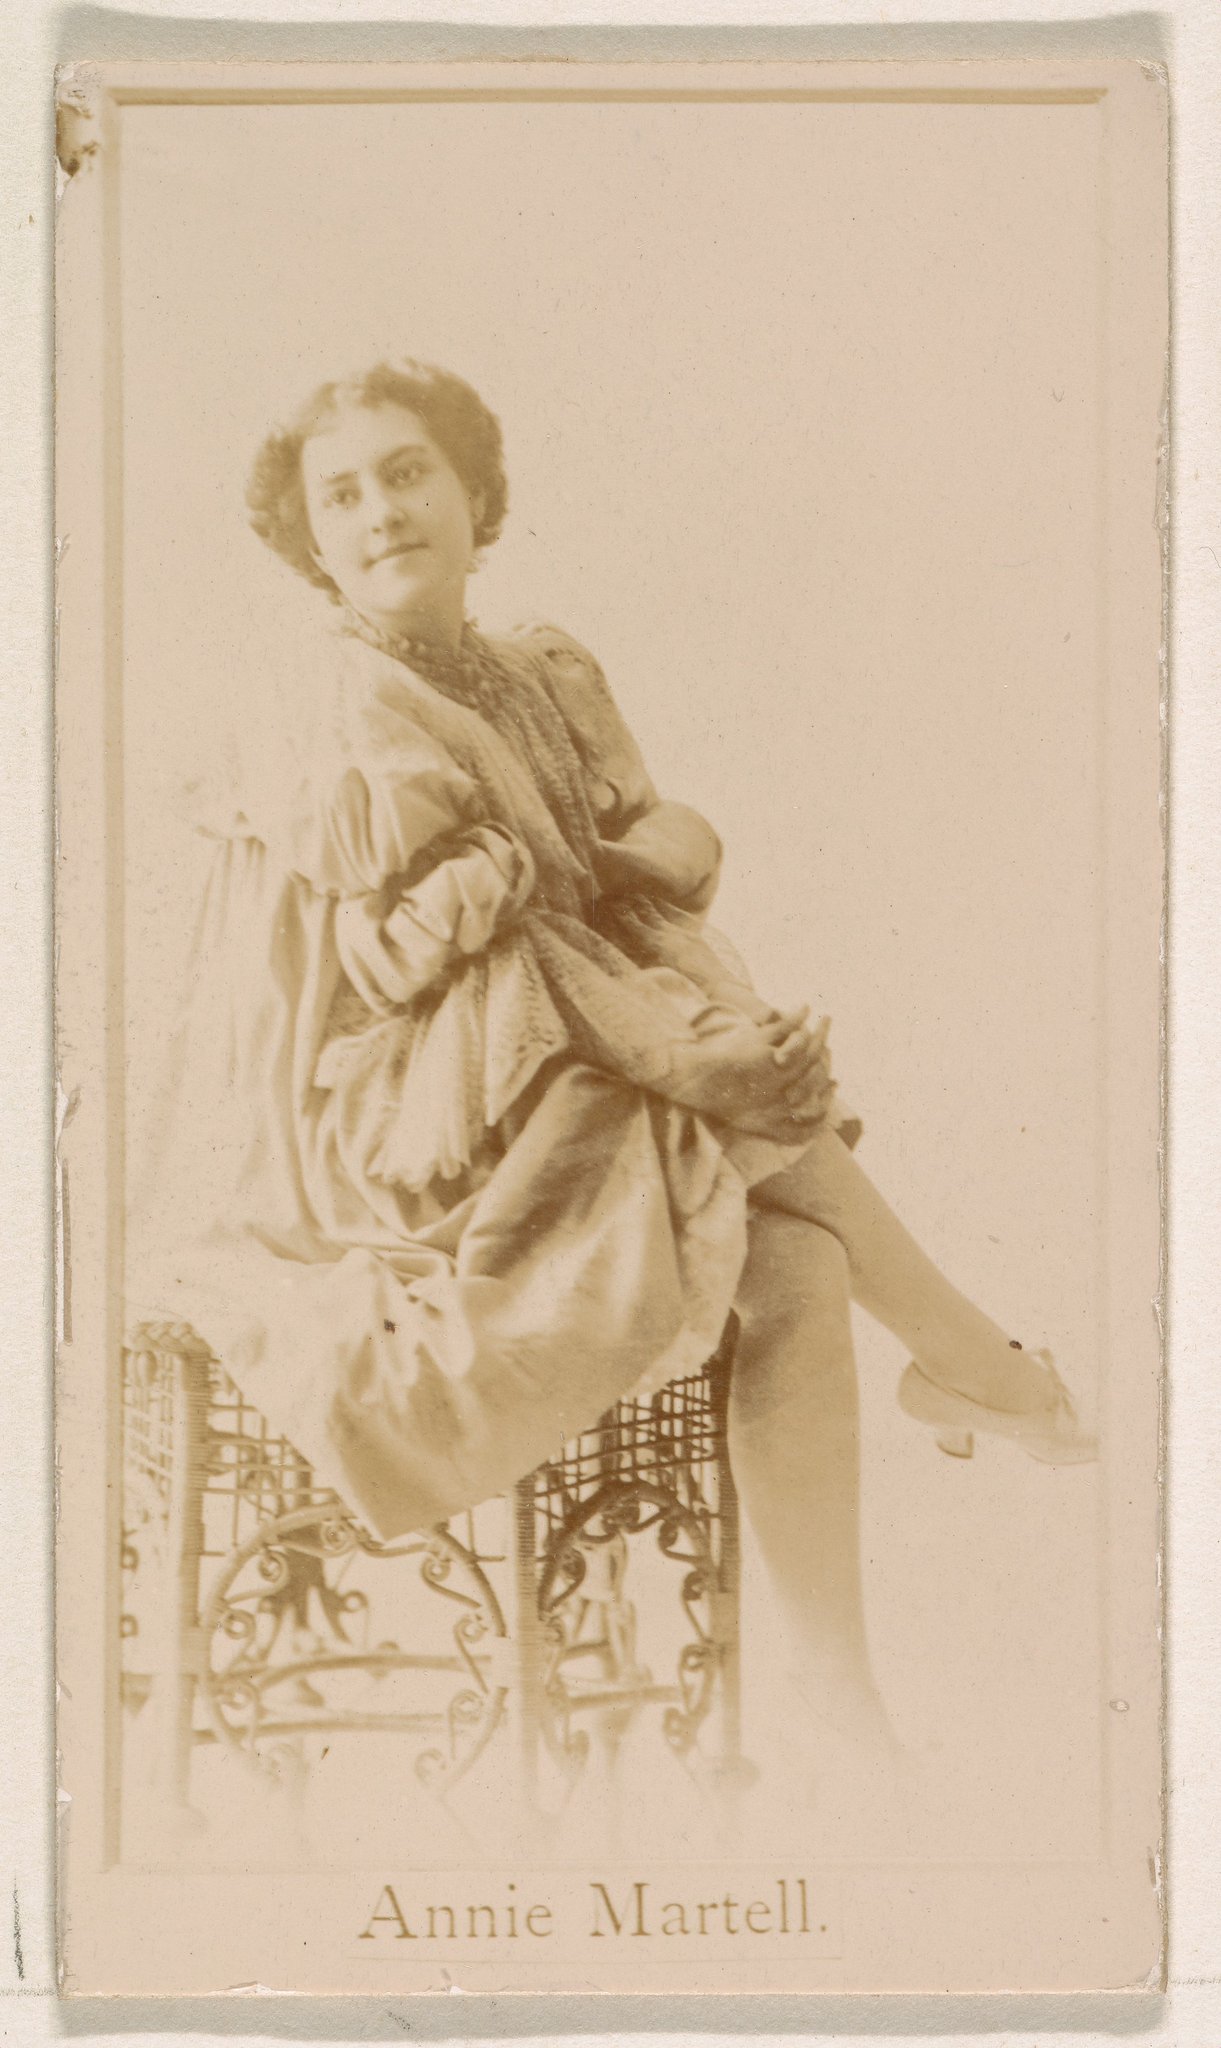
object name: photograph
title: Annie Martell, from the Actresses series (N245) issued by Kinney Brothers to promote Sweet Caporal Cigarettes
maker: kinney brothers tobacco company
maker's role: publisher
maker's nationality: american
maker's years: 1869-2011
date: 1890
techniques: albumen silver print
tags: portraits,women,actresses